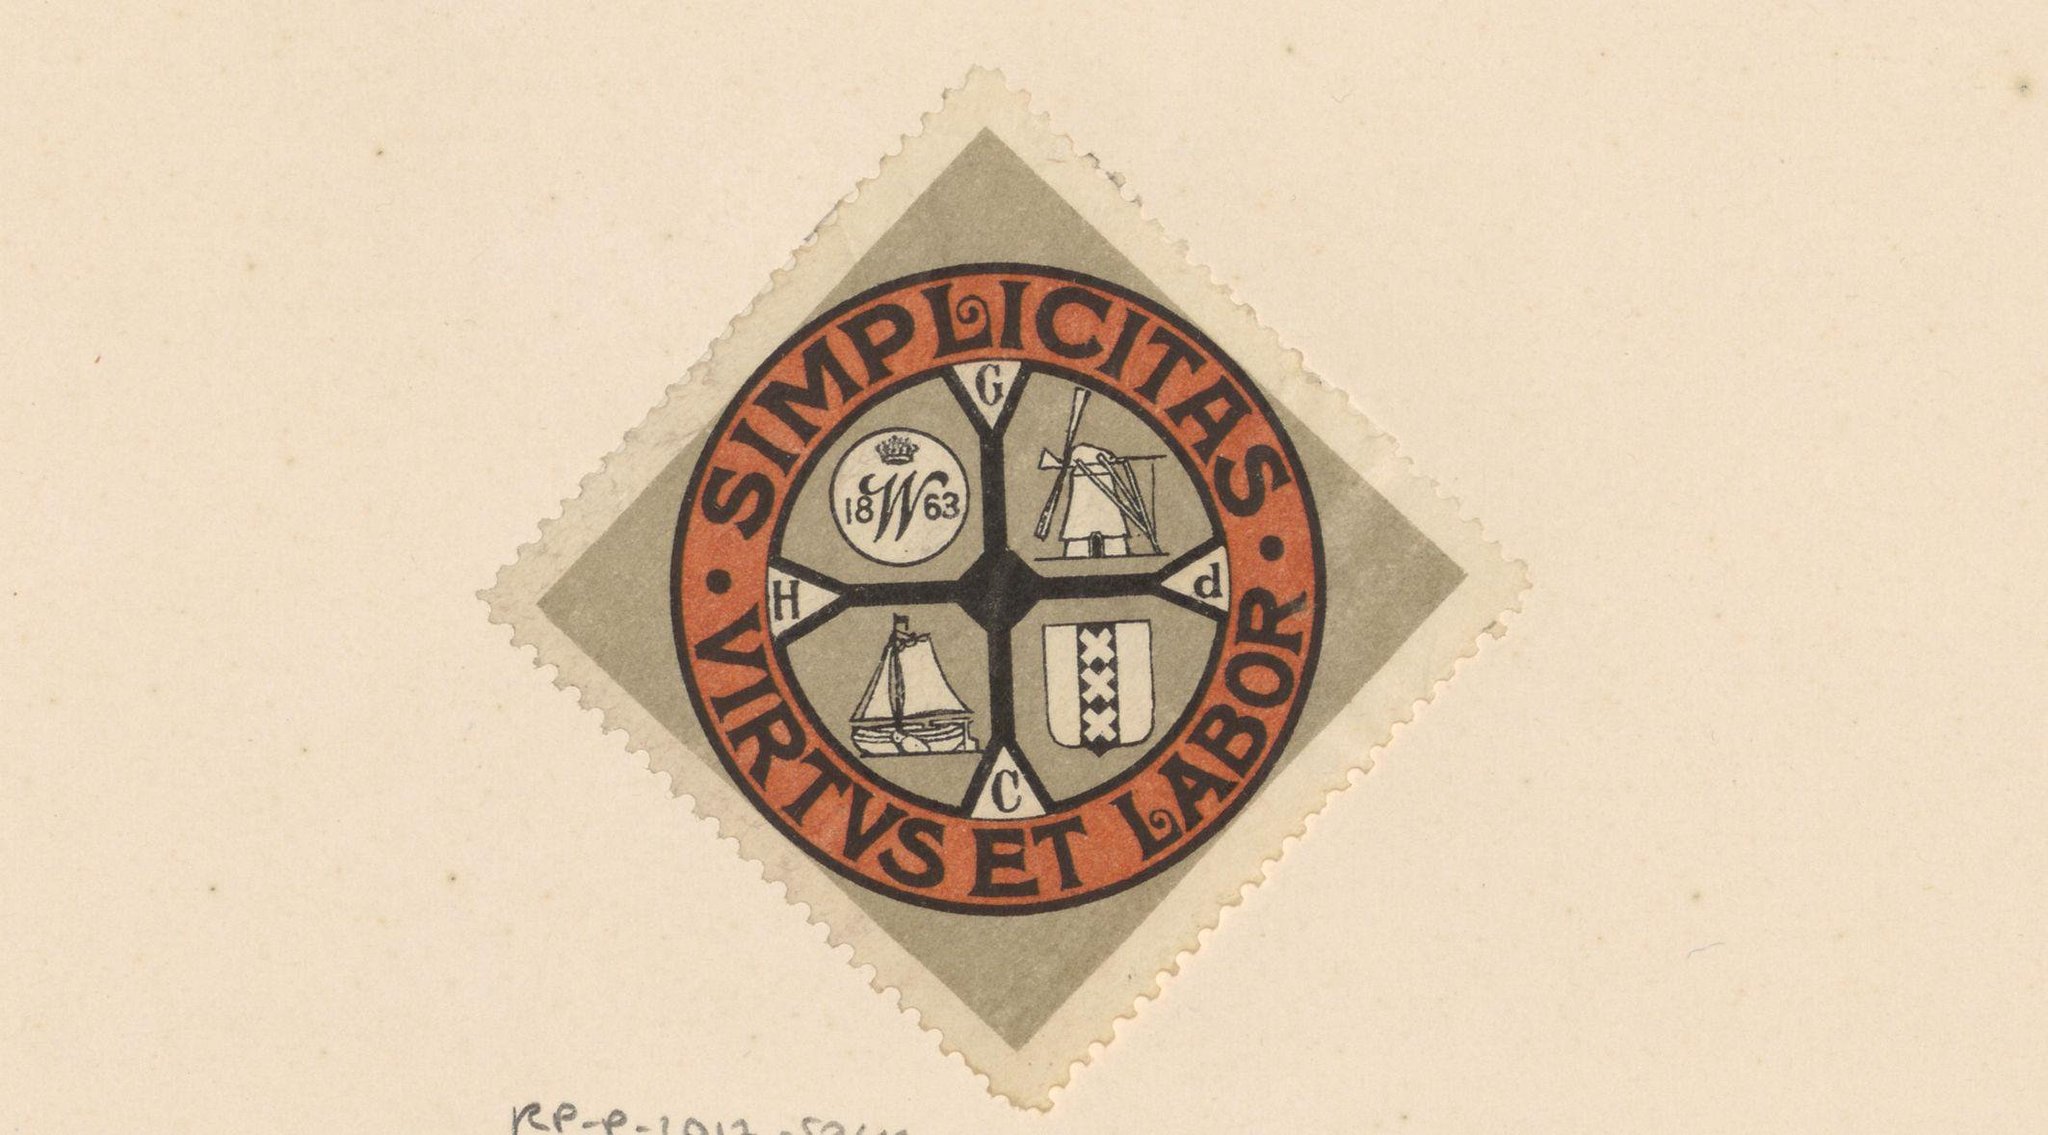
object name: bookplate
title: Simplicitas, virtus et labor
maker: Anonymous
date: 1863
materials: paper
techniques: printing block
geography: netherlands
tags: sailing-ship, sailing-boat, windmill, armorial bearing, heraldry, amsterdam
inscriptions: inscription: ‘H.G. du Crocq, / Amsterdam, Leidsche gracht 11. / Conservator / Munt- en penningkabinet / Koninklijk Oudheidkundig Genootschap / en / Koninklijk Nederlandsch Genootschap / voor munt- en penningkunde.’